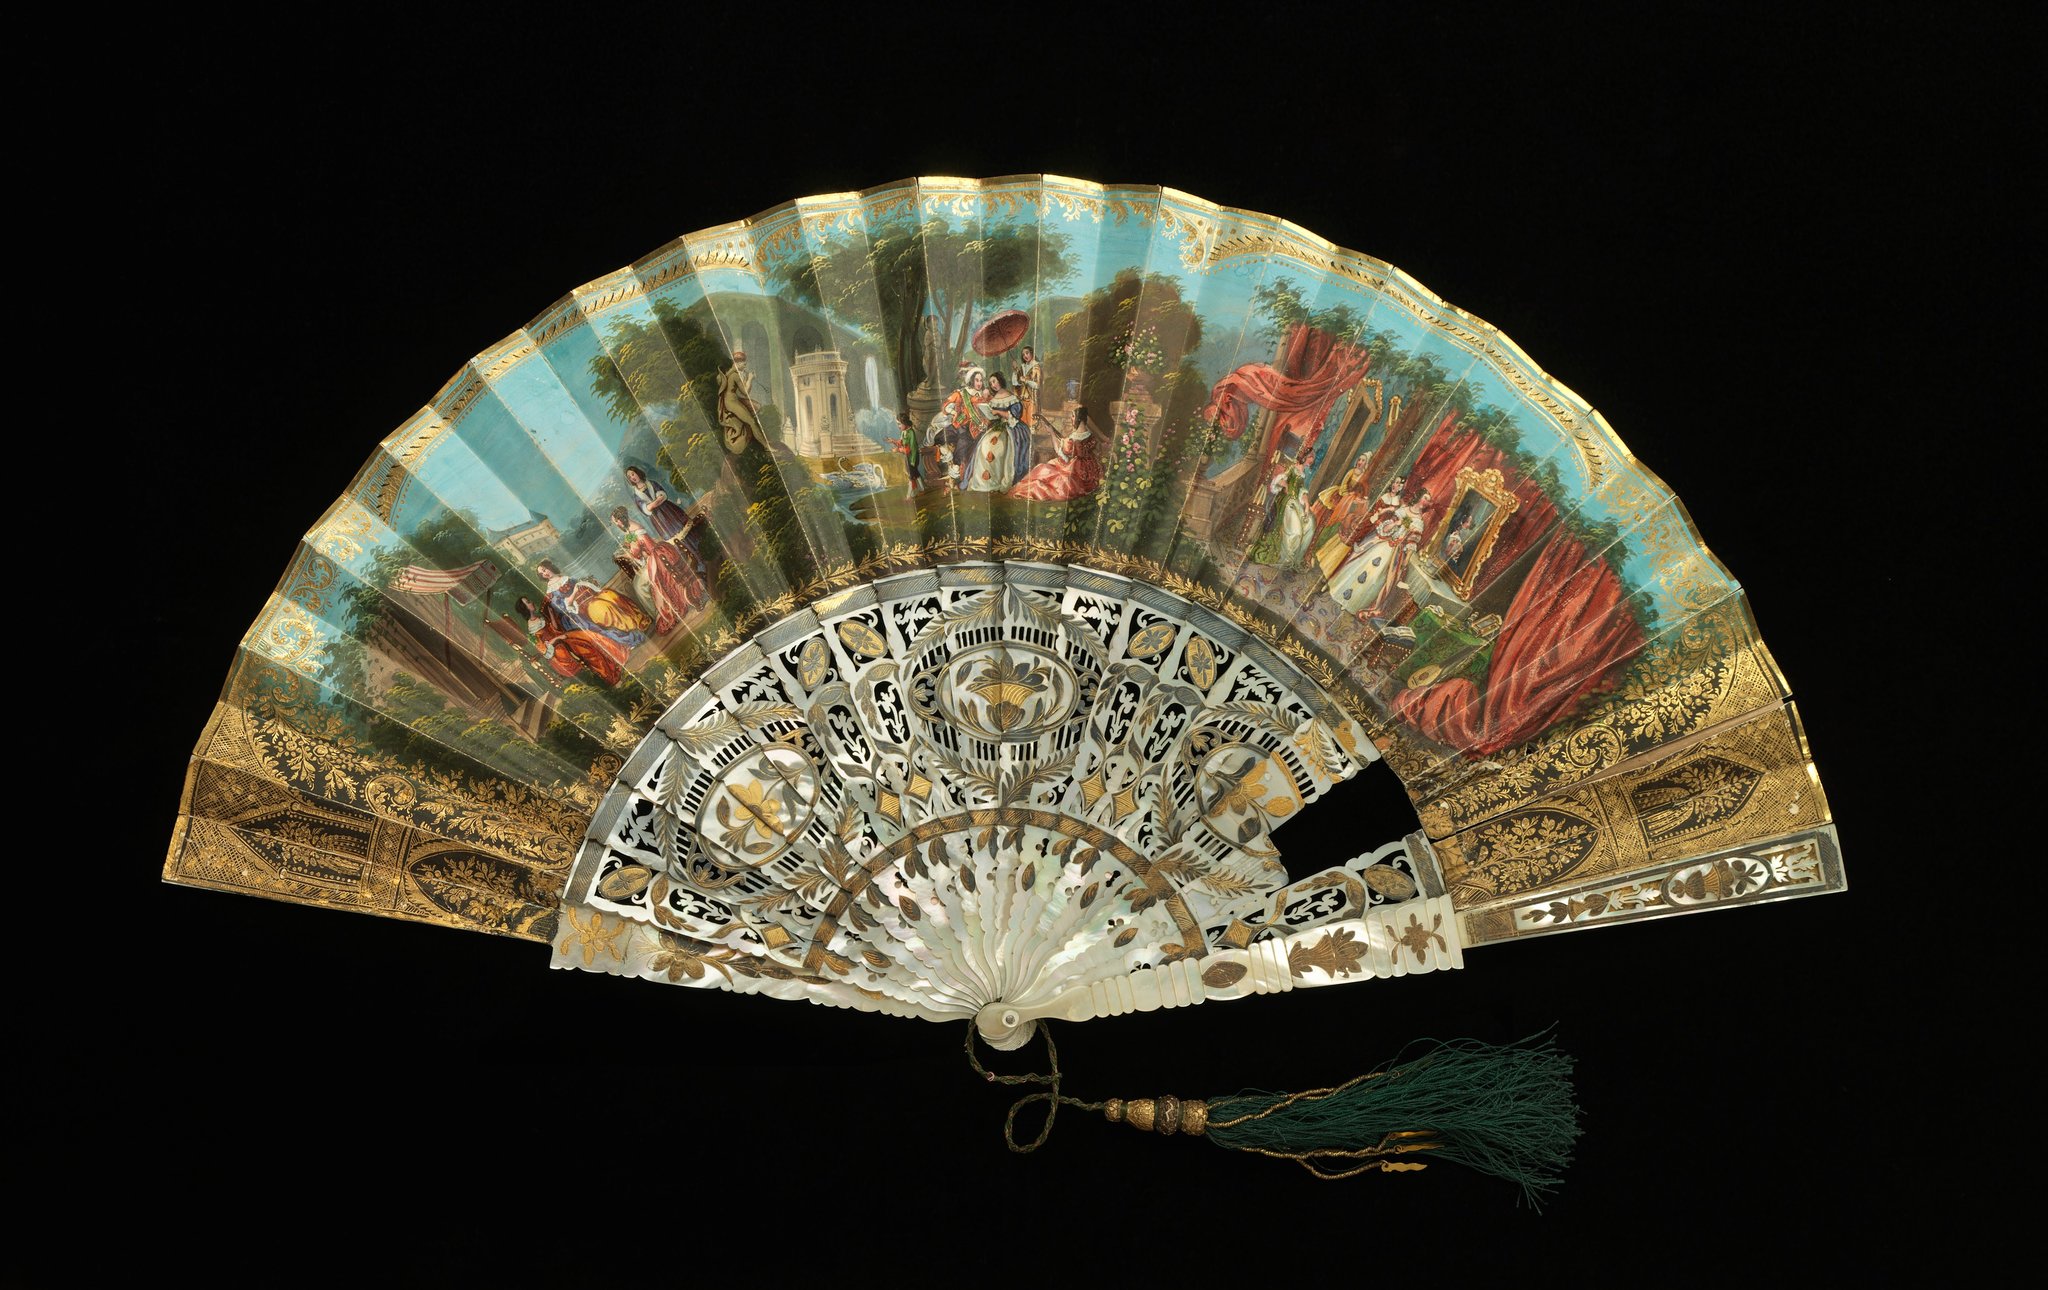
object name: fan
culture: italian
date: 1850-1870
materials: gouache, metal, mother of pearl, paper, silk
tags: men,women,dressing,needlework